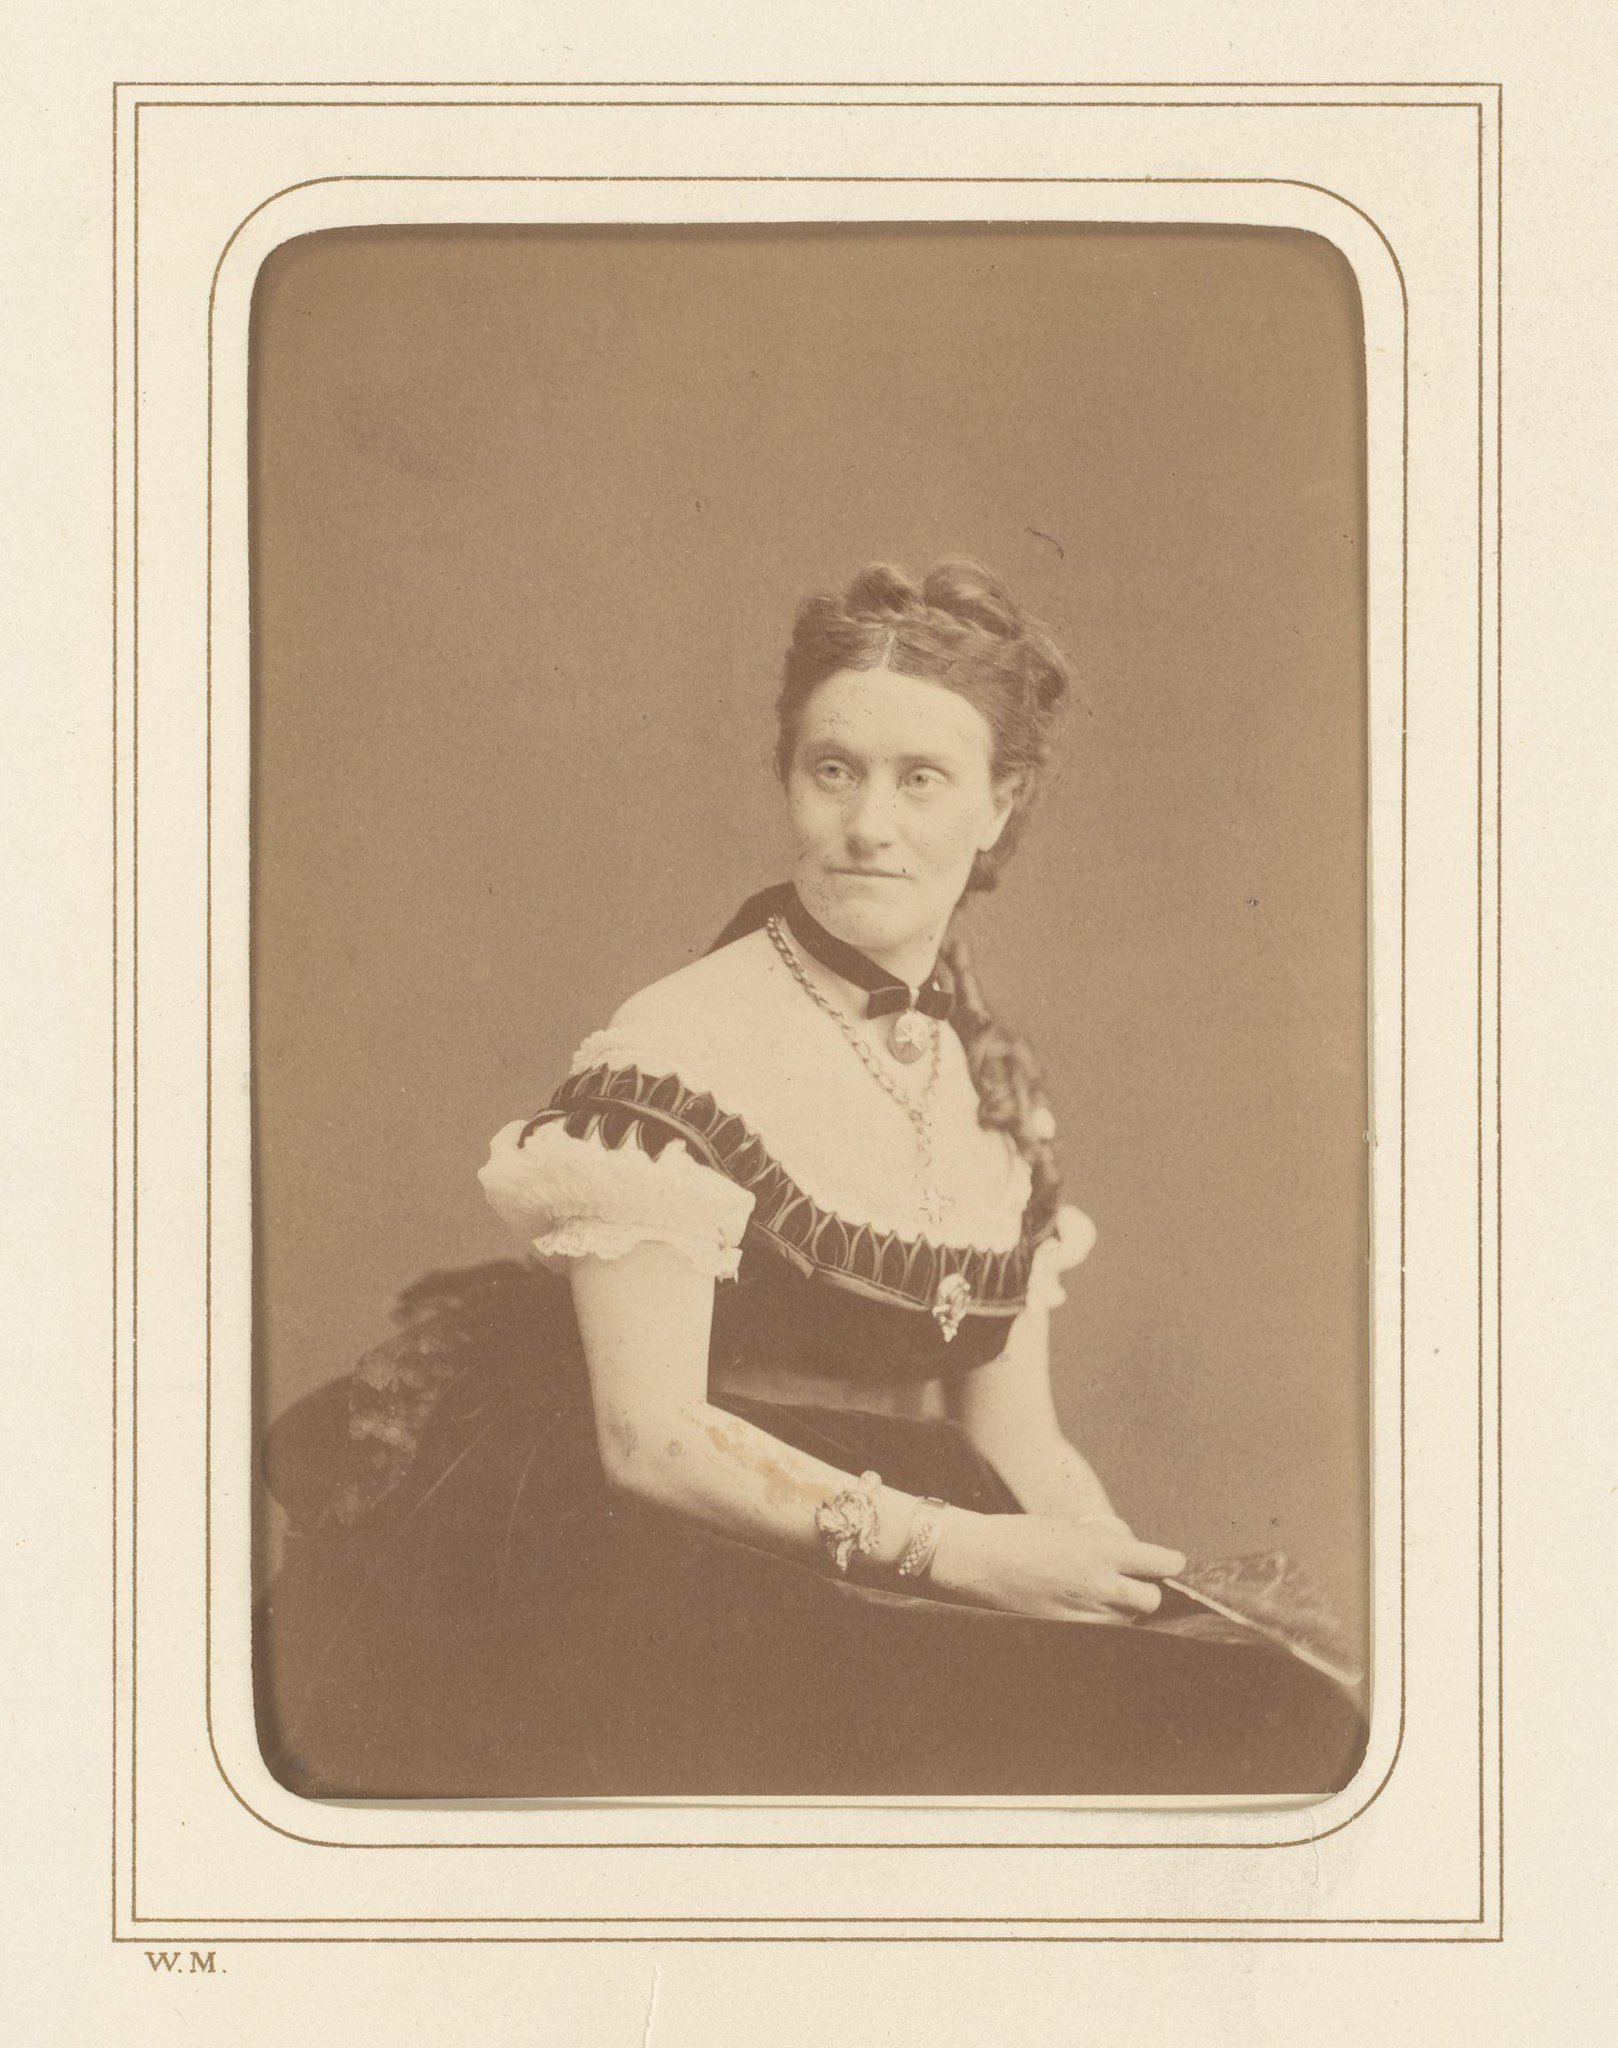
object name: album leaf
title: Portret van Louise Michaeli, zittende actrice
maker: gösta florman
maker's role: fotograaf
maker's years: 1831-1900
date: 1855-1875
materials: cardboard, photographic support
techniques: albumen print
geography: stockholm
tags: historical persons - bb - woman, portrait of actor, actress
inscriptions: annotation: ‘Louise Michaeli/ 1830 - 1875’, inscription: ‘GÖSTA FLORMAN/ CABINET PORTRAIT/ STOCKHOLM/ Regeringsgatan 28.A’